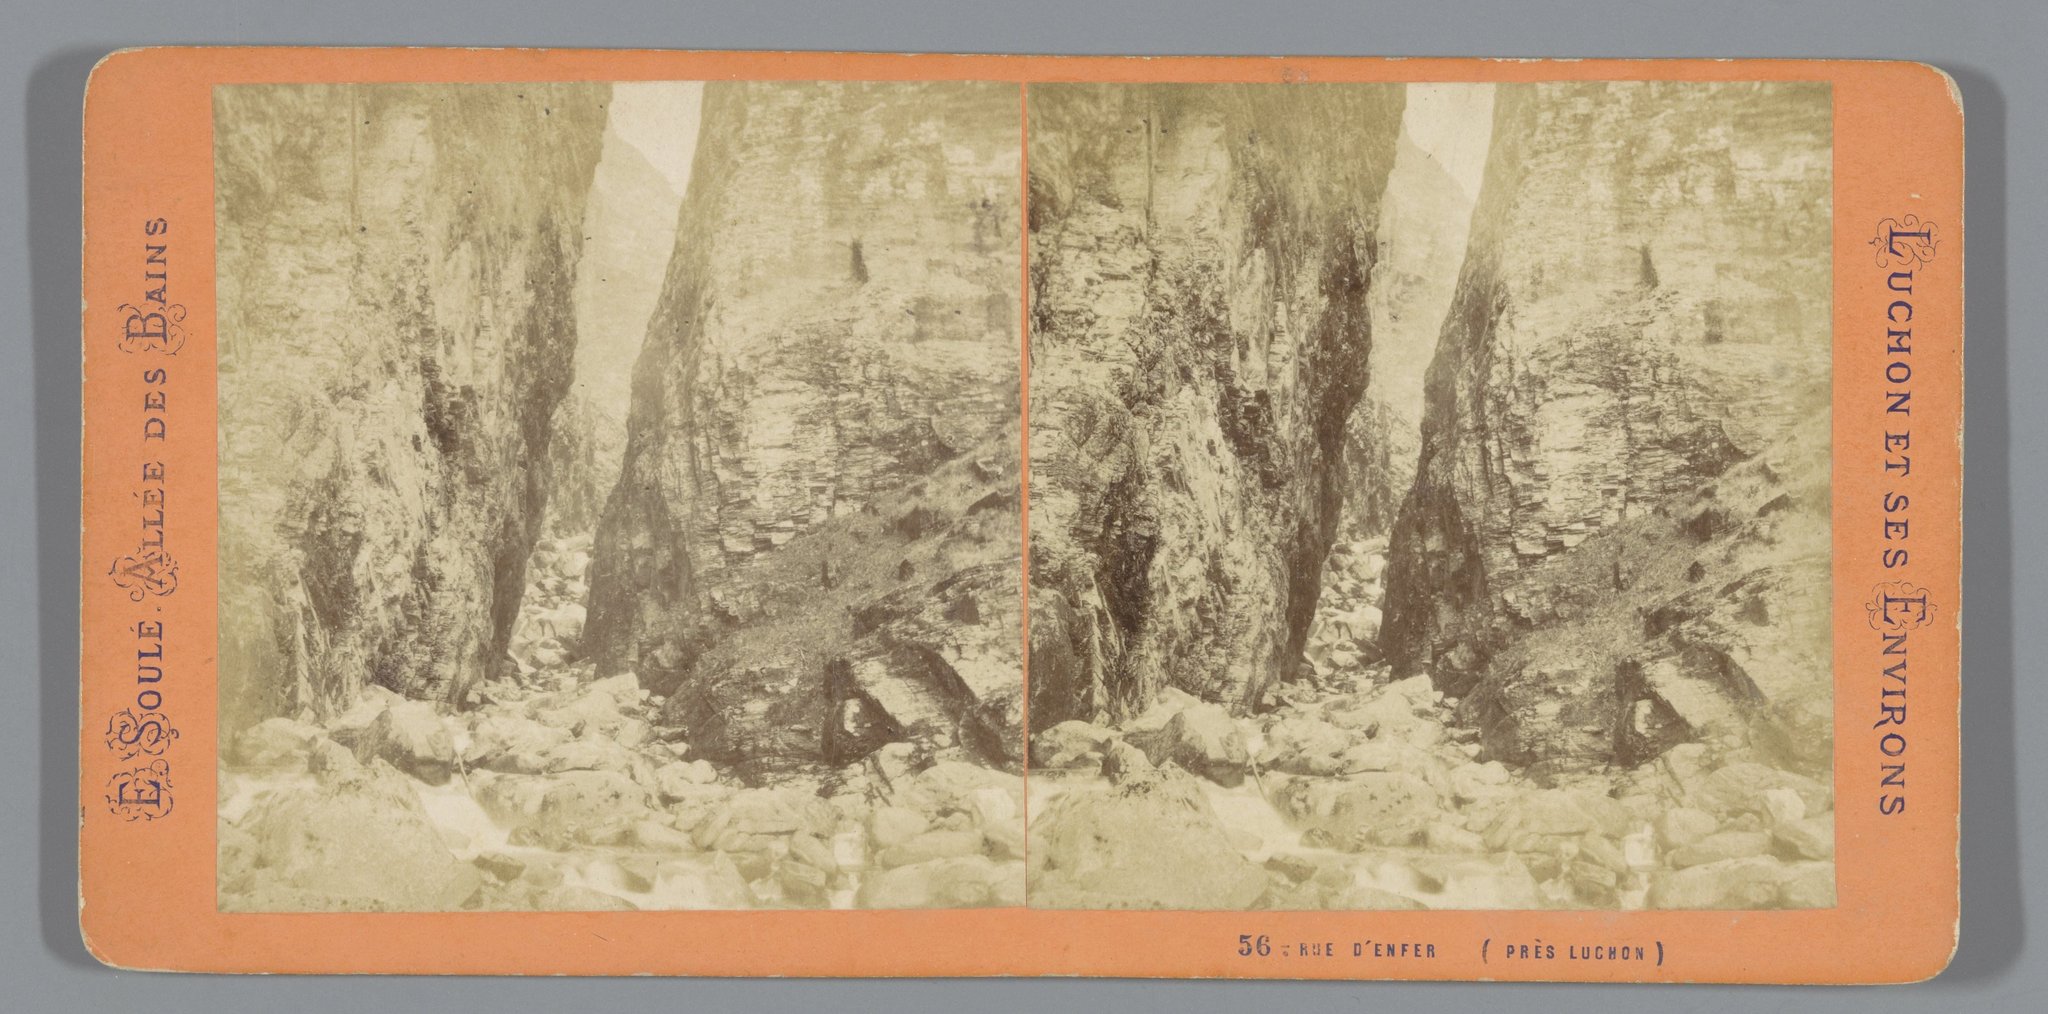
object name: stereograph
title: Rue d'Enfer (pres Luchon)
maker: e. soule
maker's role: fotograaf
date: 1860-1880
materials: cardboard, photographic support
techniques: albumen print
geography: pyrenees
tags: ravine, chasm, abyss, canyon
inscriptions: number: ‘56’